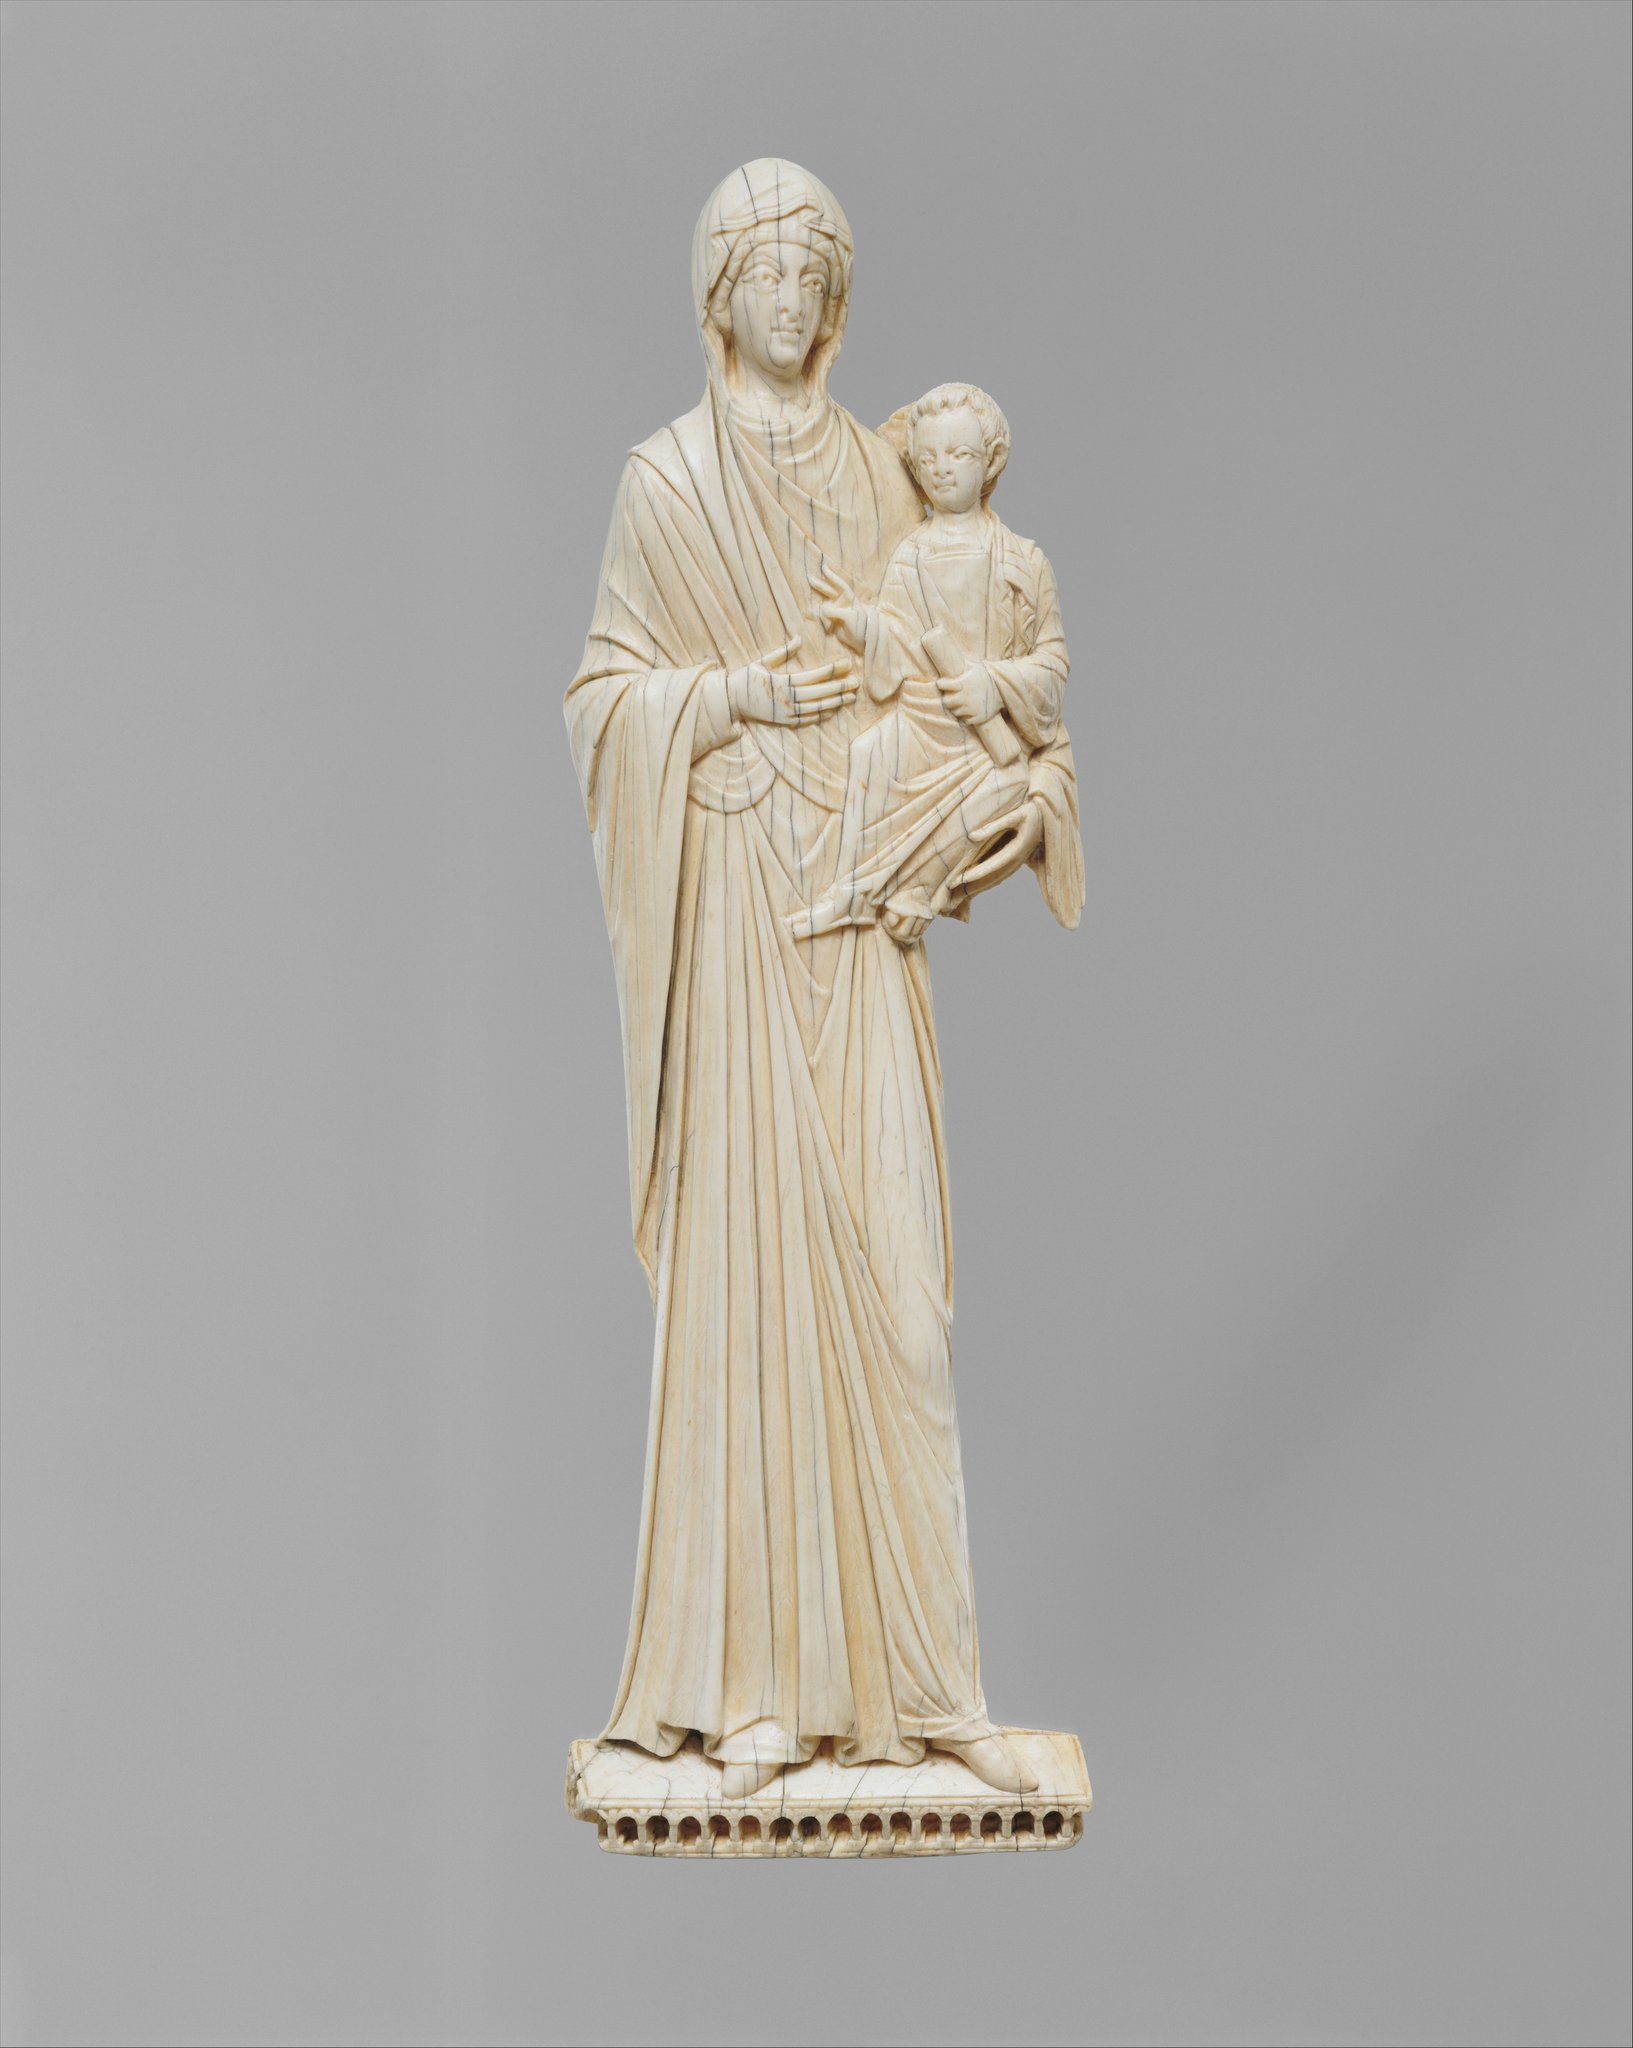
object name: plaque fragment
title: Icon with the Virgin and Child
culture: byzantine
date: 934-1066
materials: ivory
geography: probably constantinople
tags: madonna and child